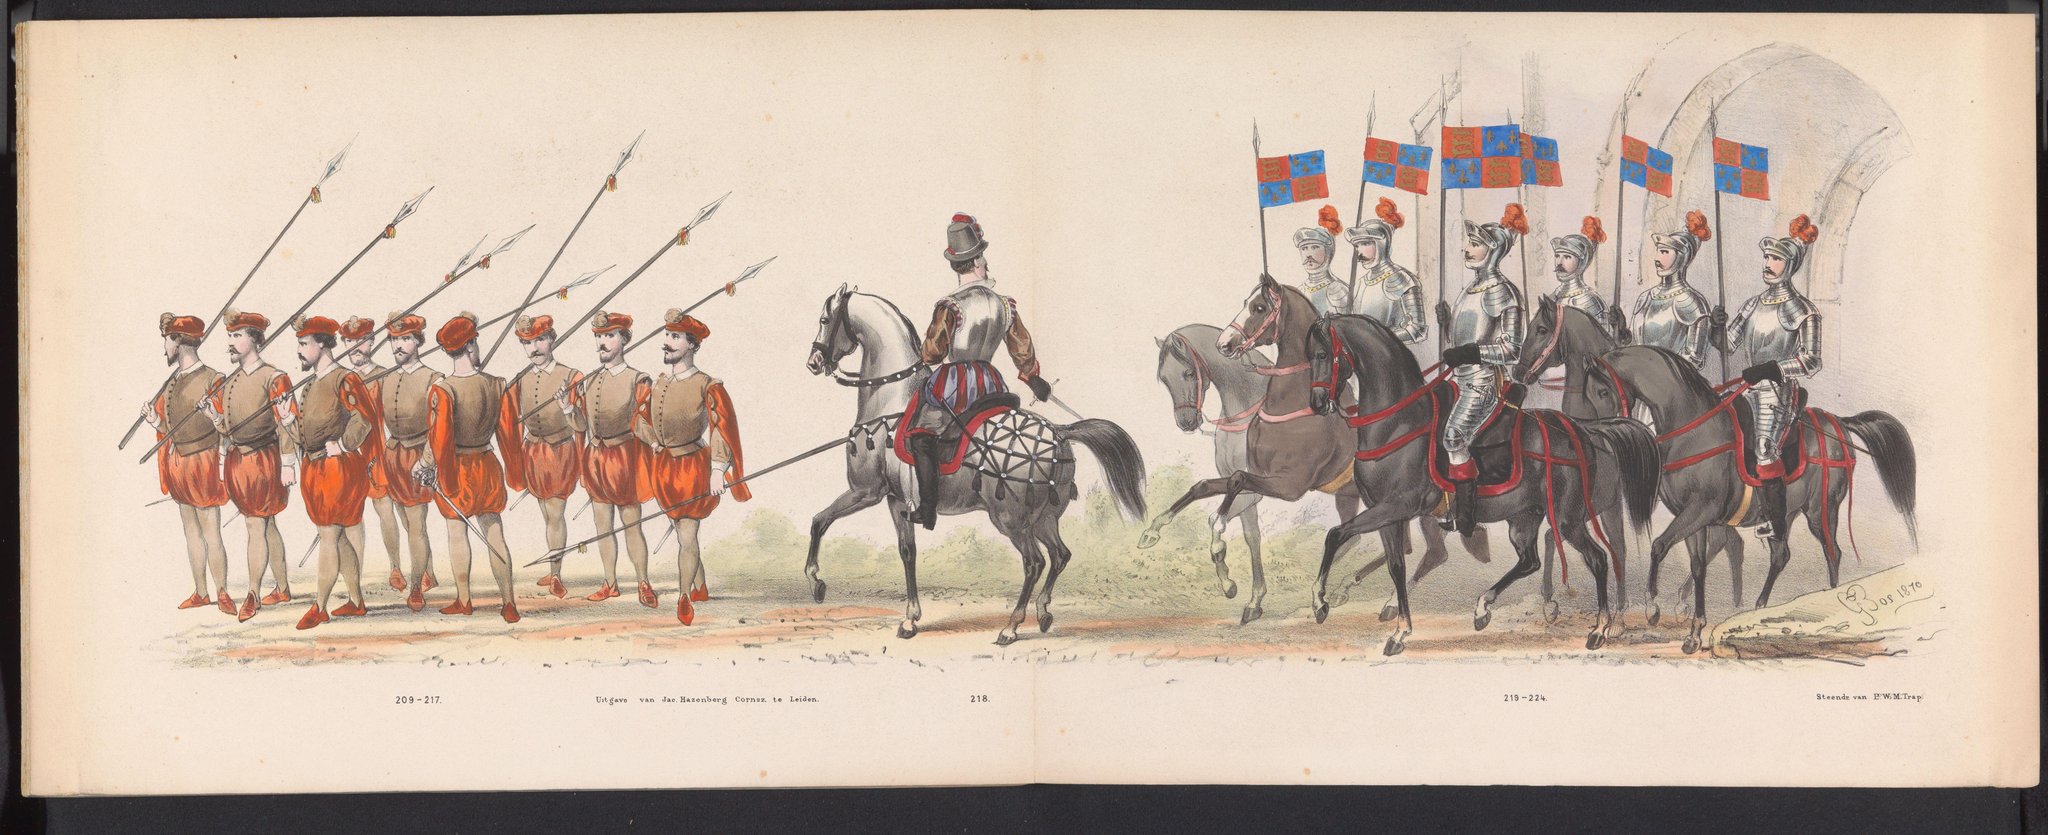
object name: print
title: Gecostumeerde optogt gehouden door de leden van het Leidsche studentencorps den 7den Junij 1870, ter viering van den 295sten verjaardag der Leidsche Hoogeschool, voorstellende bezoek gebragt aan Leiden in 1586, door Robert Lord Dudley, Baron van Denbigh, Graaf van Leicester, enz. enz.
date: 1870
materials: paper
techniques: hand coloring, lithograph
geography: leiden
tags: robert dudley (1st earl of leicester), students' pageant, costumes used in pageants, leiden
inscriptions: date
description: Historische gekostumeerde optocht van de studenten van de Leidse Hogeschool gehouden op 7 juni 1870 ter gelegenheid van het 295-jarig bestaan van de Hogeschool. De optocht verbeeldt de intocht van de Graaf van Leicester in Leiden in 1586. Achttiende plaat met de groepen genummerd 209-224. Onderdeel van de serie van 18 aaneen geplakte bladen.